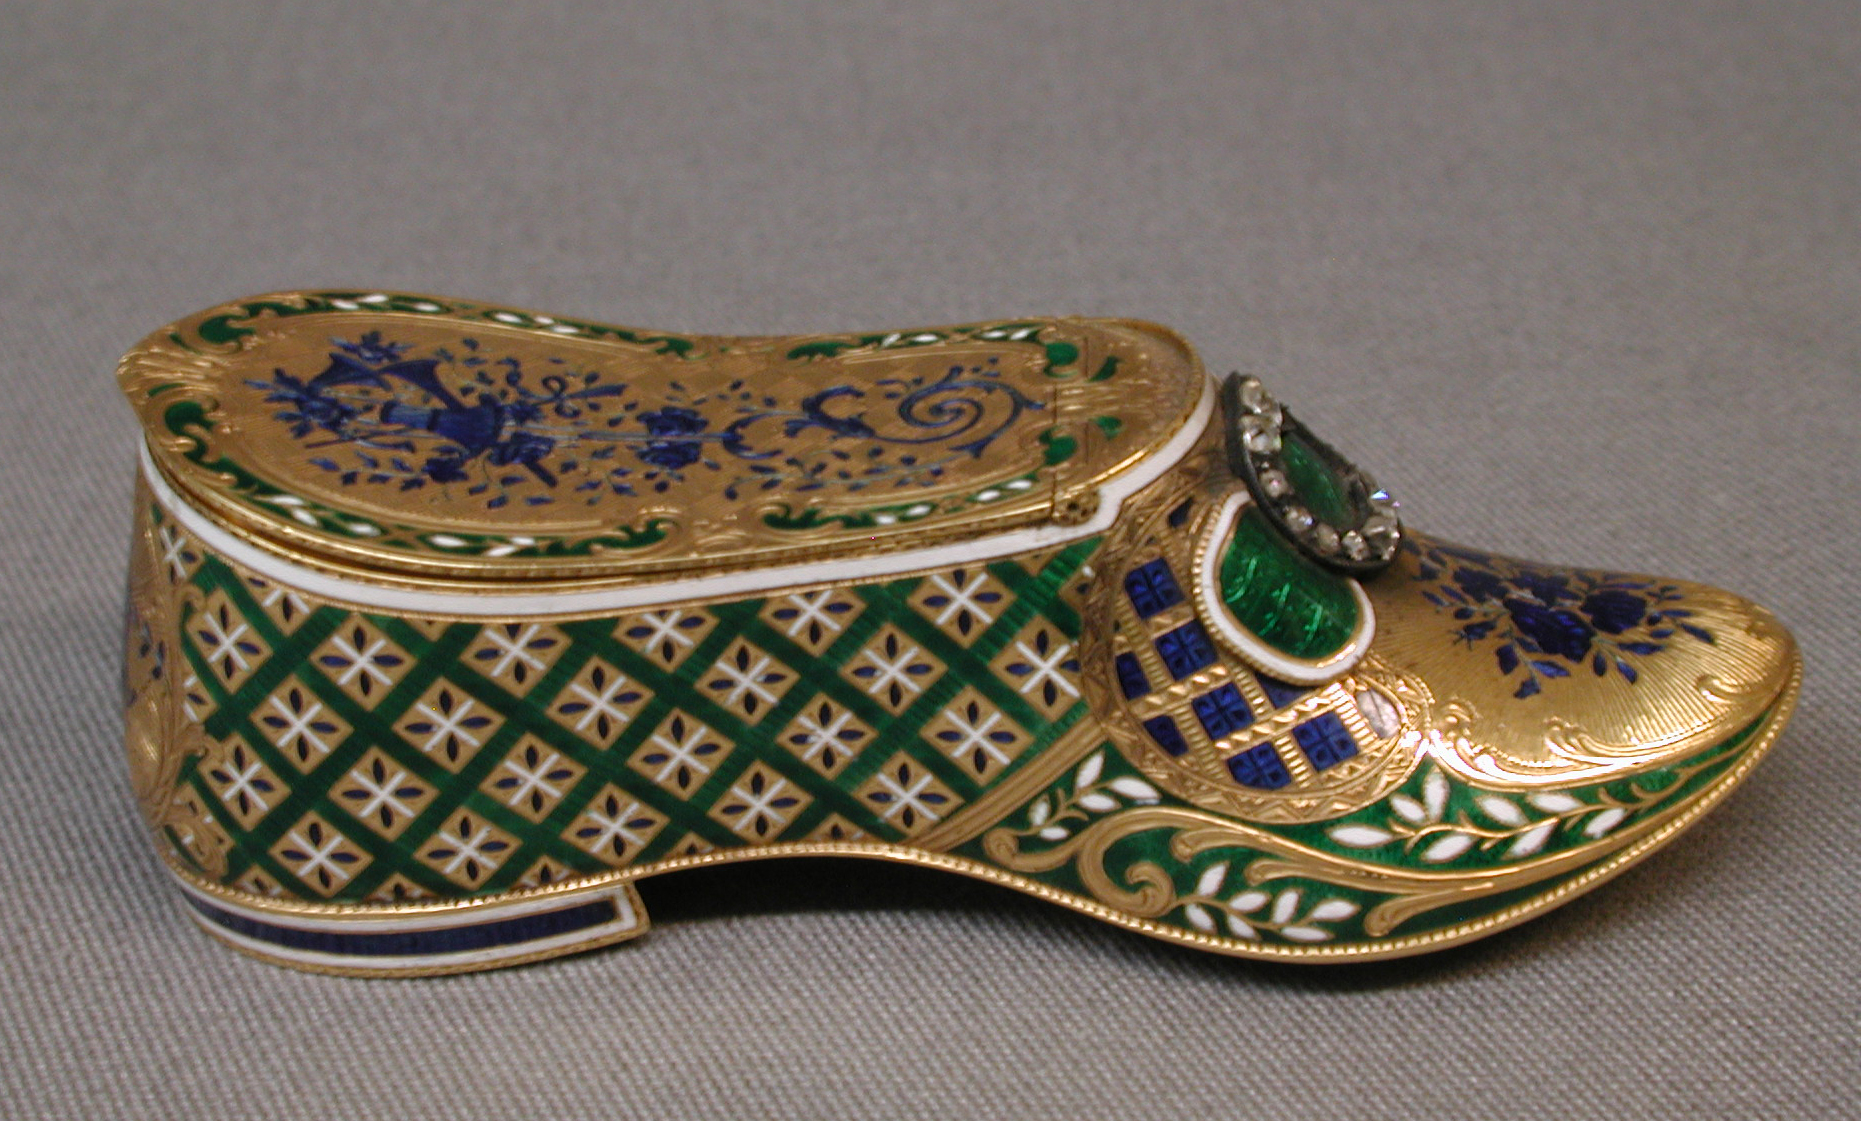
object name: musical snuffbox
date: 1801-1900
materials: diamond, enamel, gold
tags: flowers